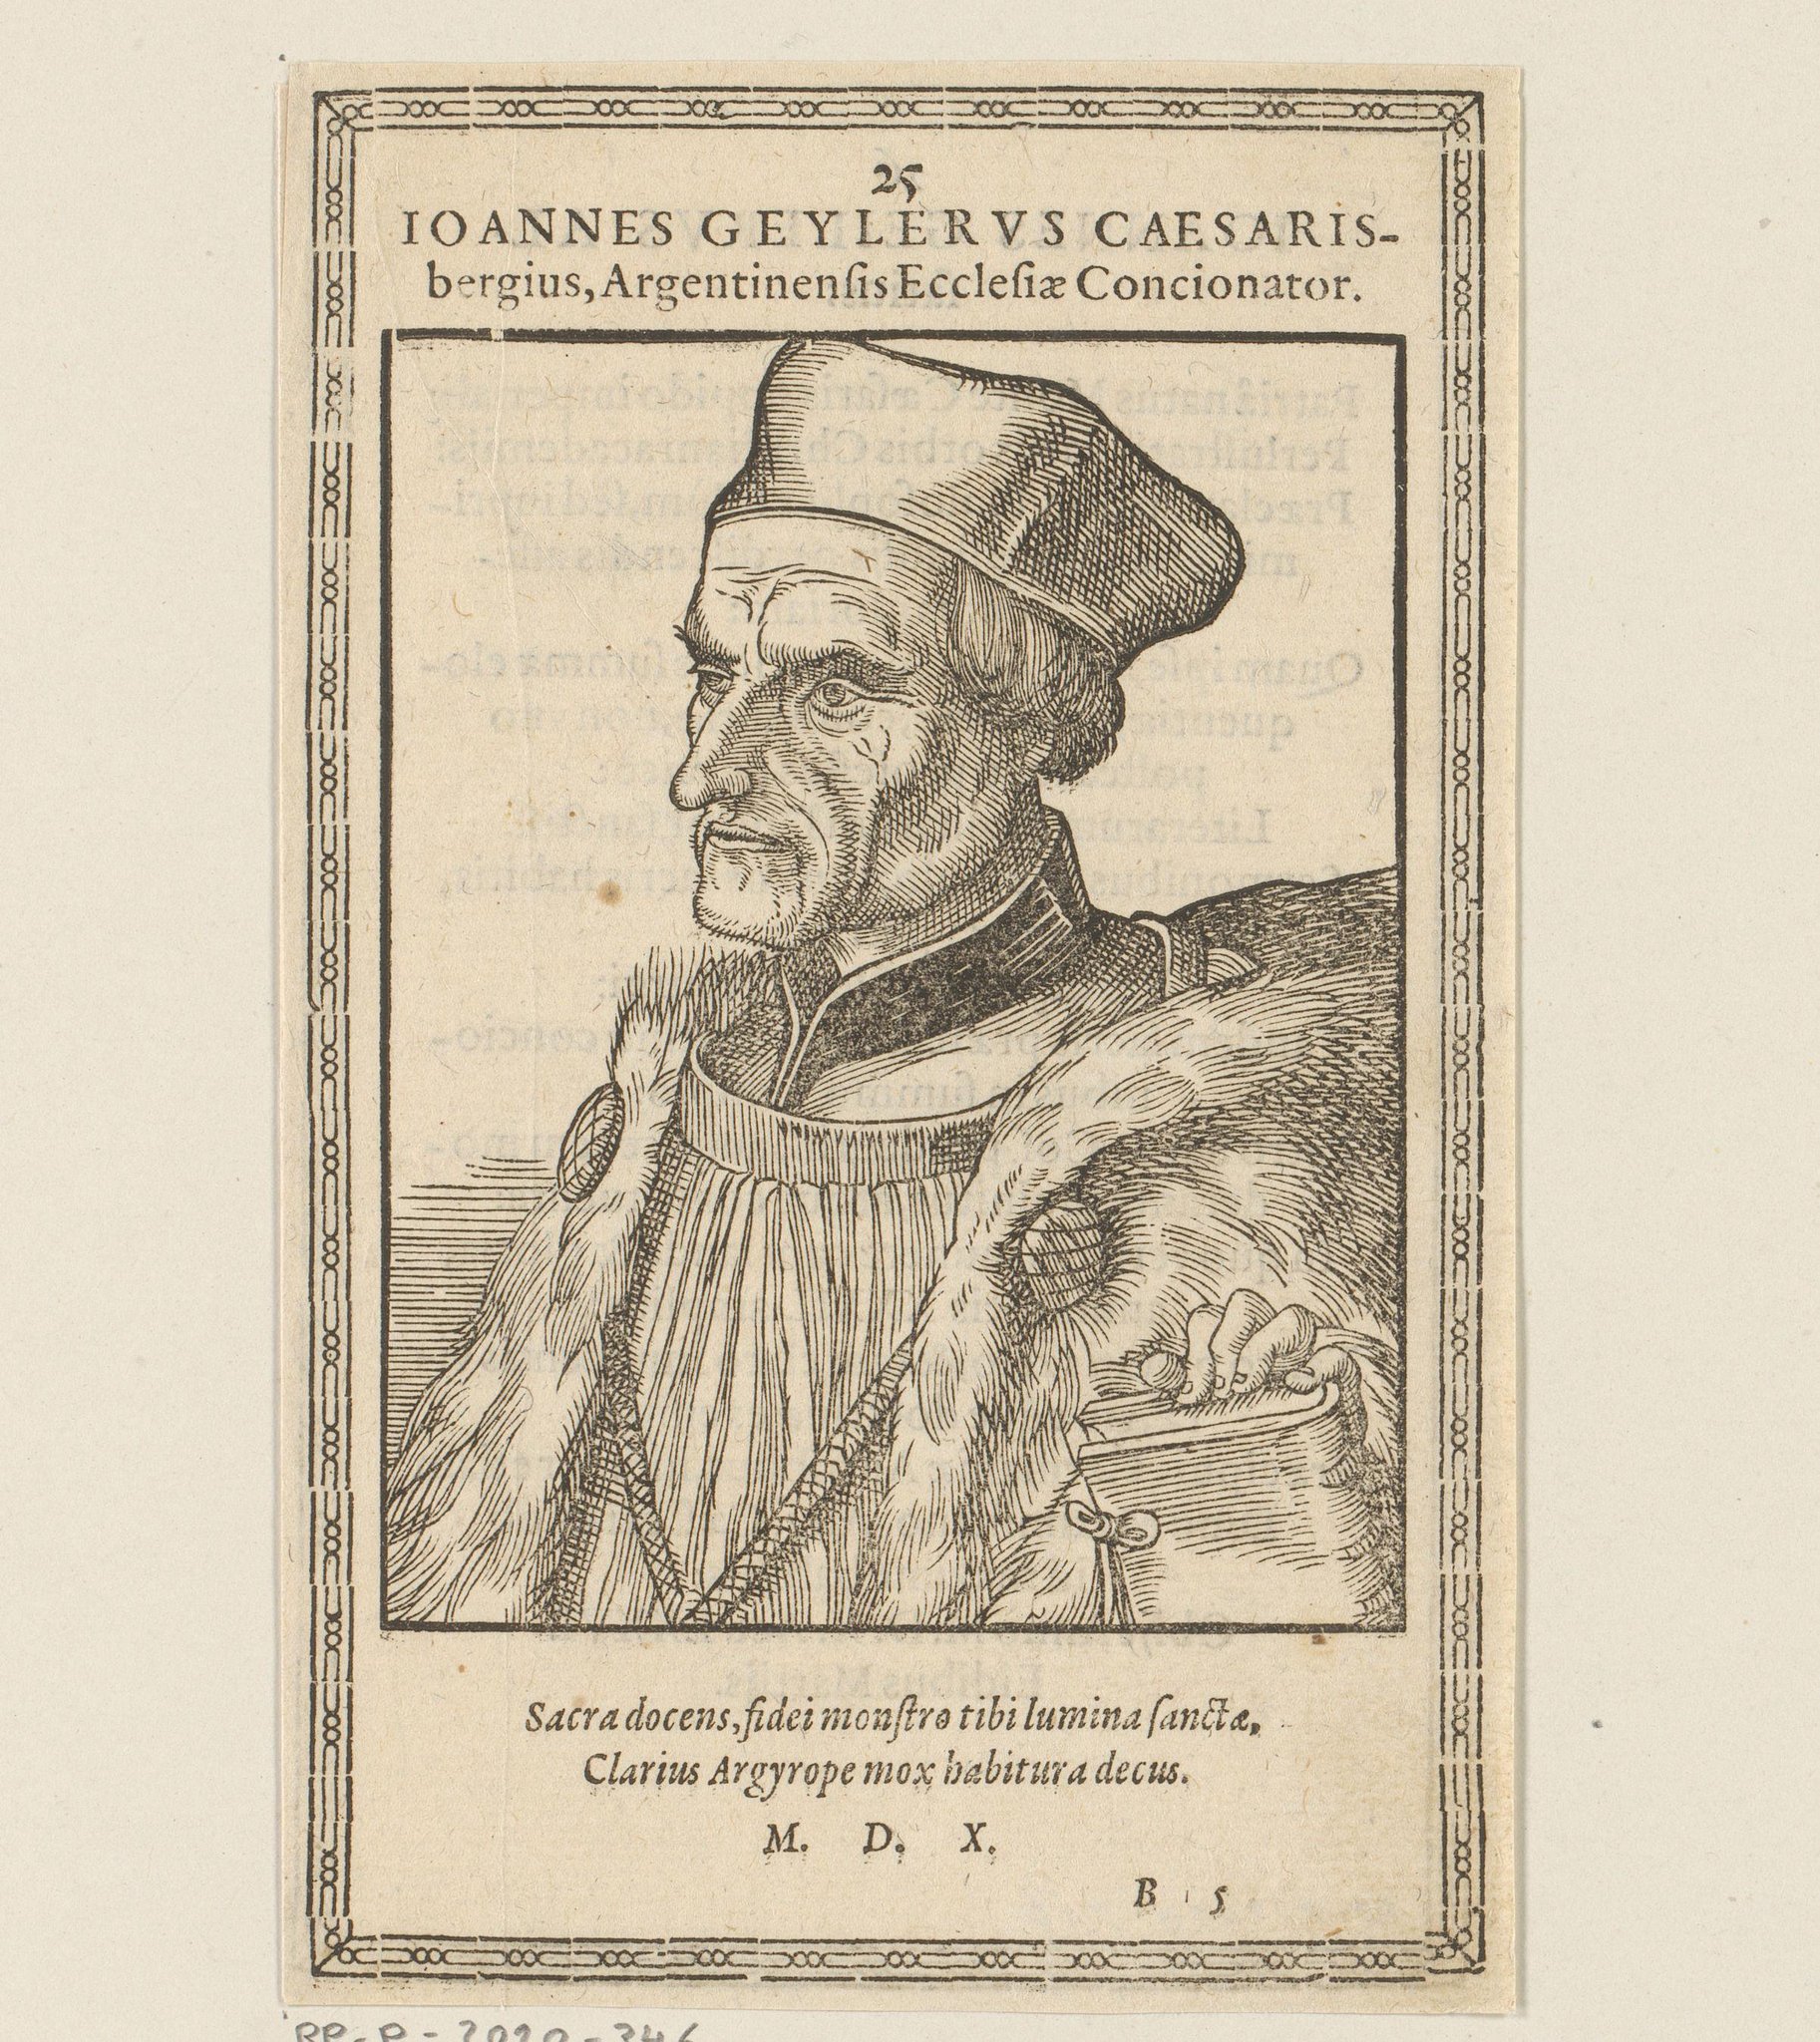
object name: print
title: Portret van Johann Geiler von Kaisersberg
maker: bernhard jobin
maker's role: printer, publisher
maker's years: 1545-1593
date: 1590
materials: paper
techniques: letterpress printing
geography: straatsburg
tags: priest (roman catholic), historical persons, book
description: Prent uit: Reusner, Nikolaus. Icones sive imagines virorum literis illustrium (...). Straatsburg: Bernhard Jobin, 1590, p. 25. Prent voor het eerst verschenen in de eerste editie van 1587. Prent ook gebruikt in latere publicaties.